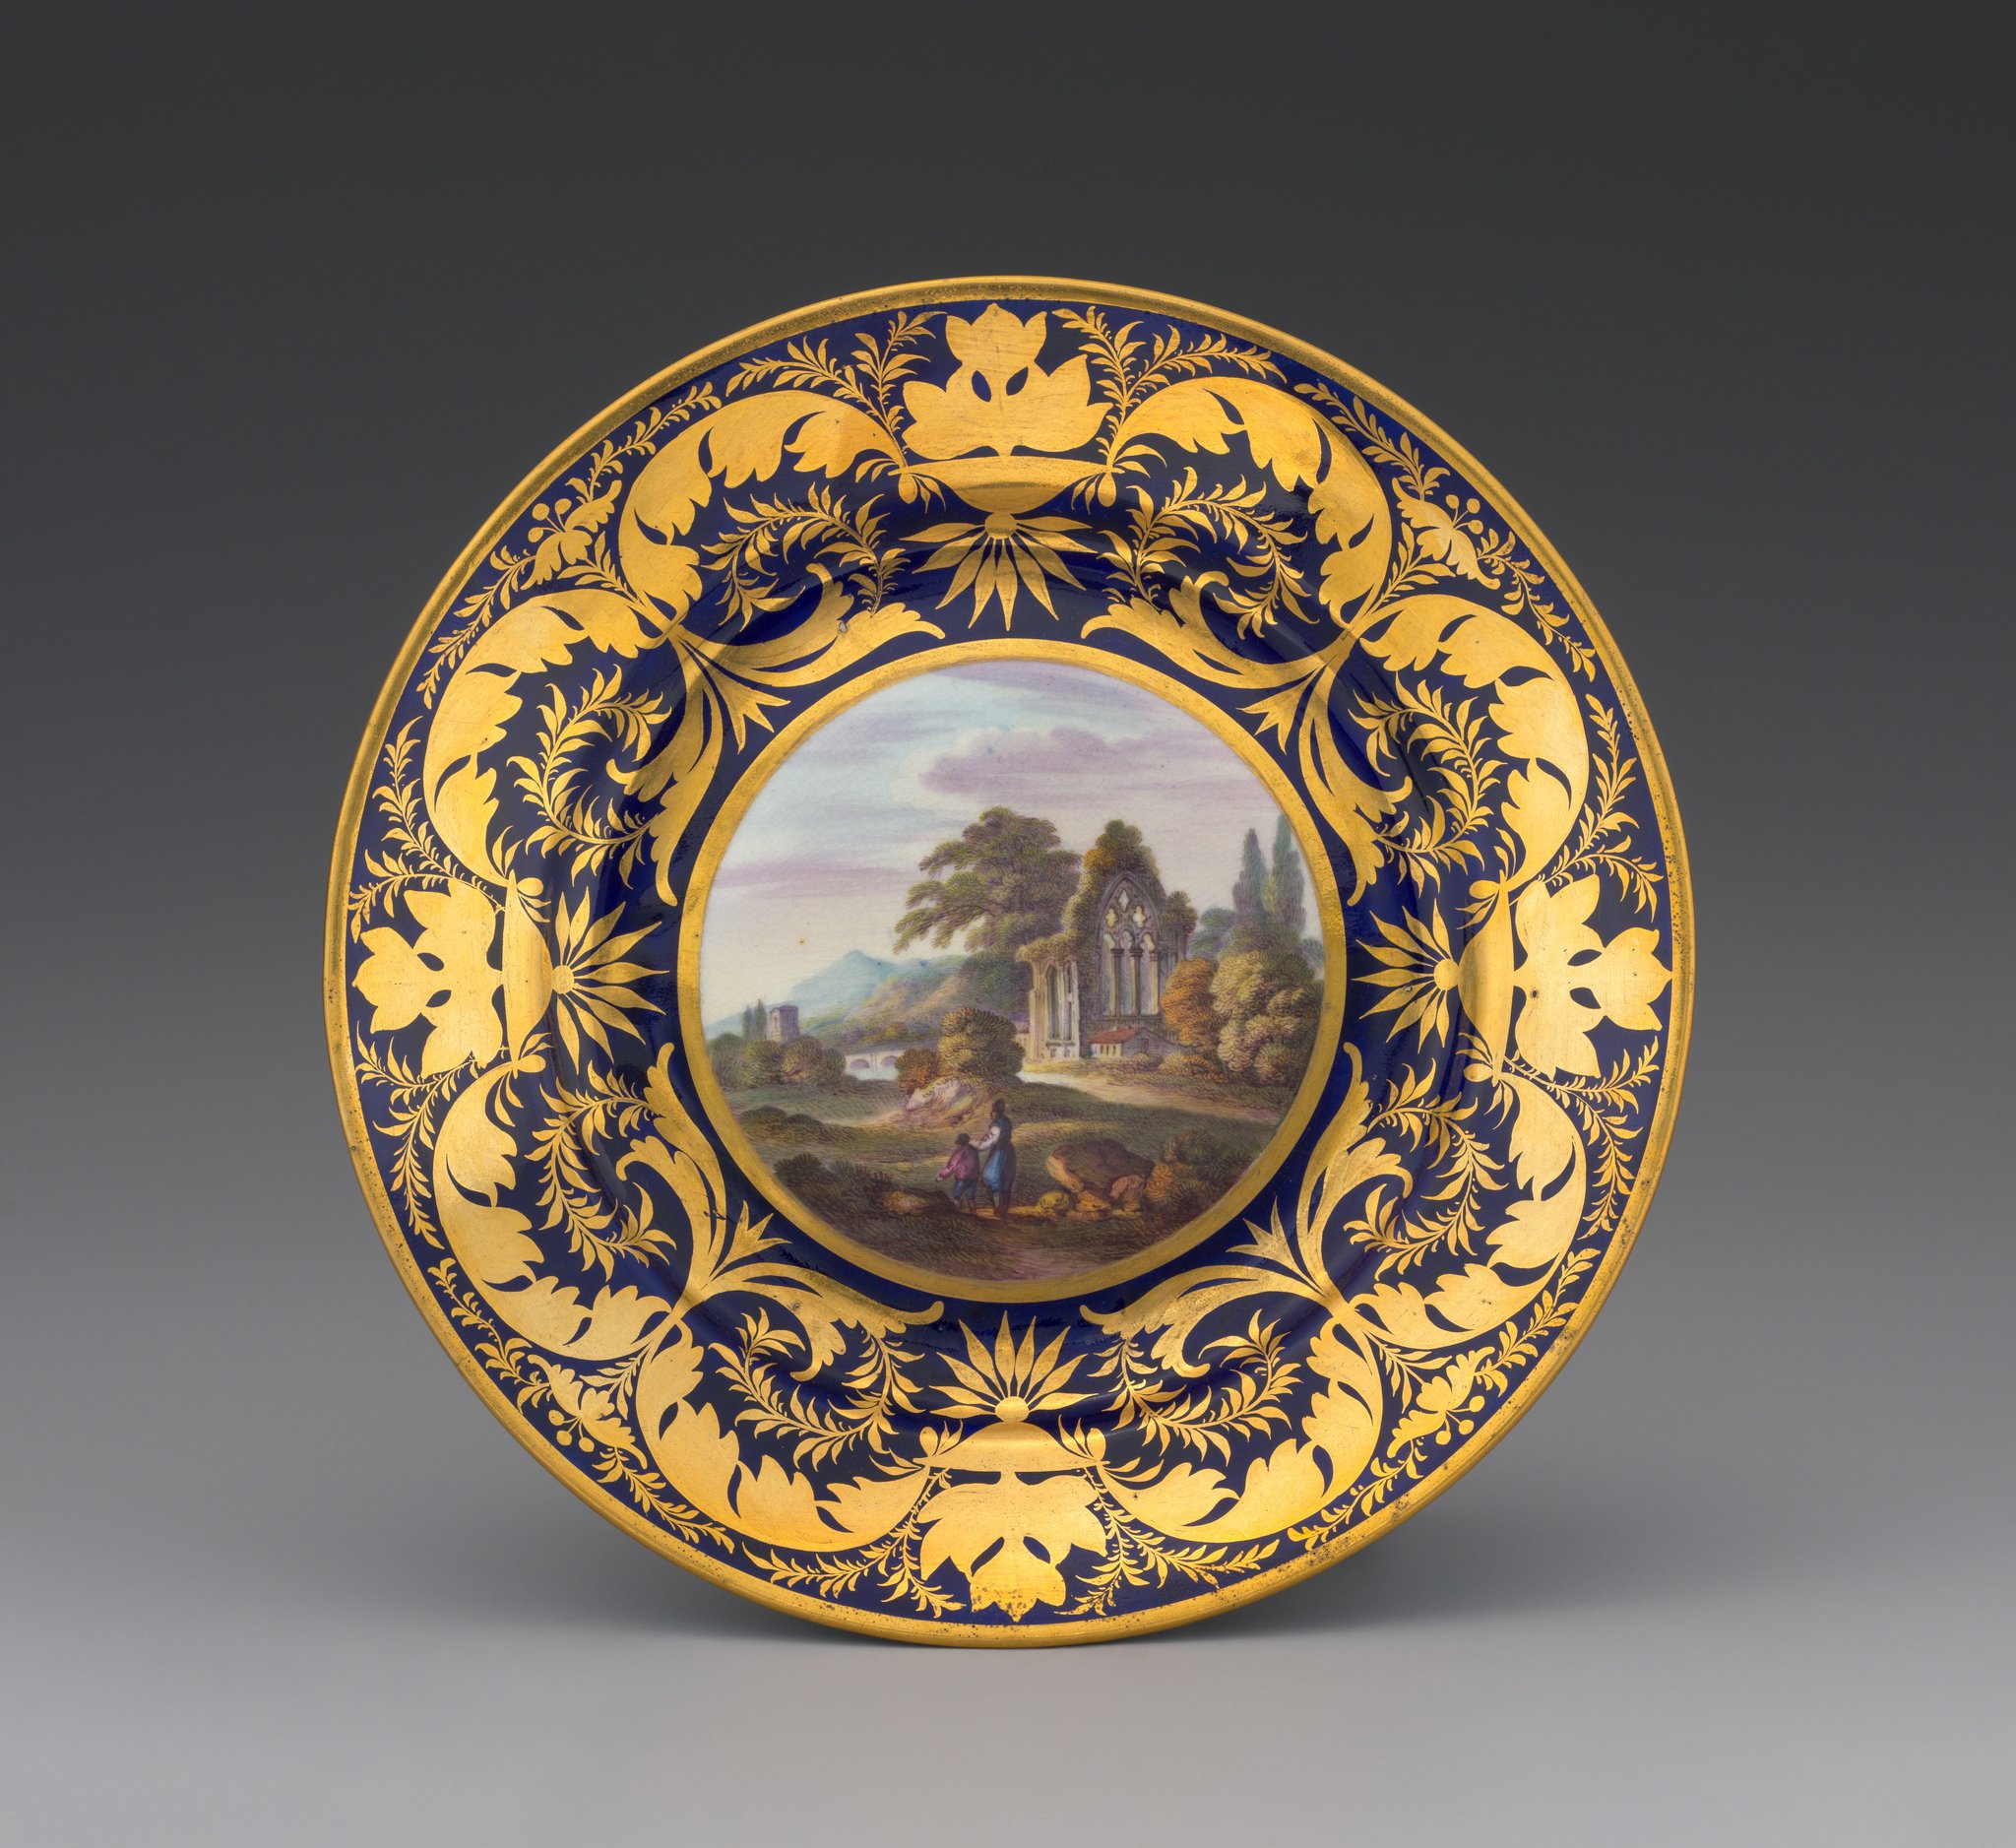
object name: plate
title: Plate (part of a service)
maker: crown derby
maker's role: maker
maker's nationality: british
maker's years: 1750-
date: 1810-1830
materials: bone china